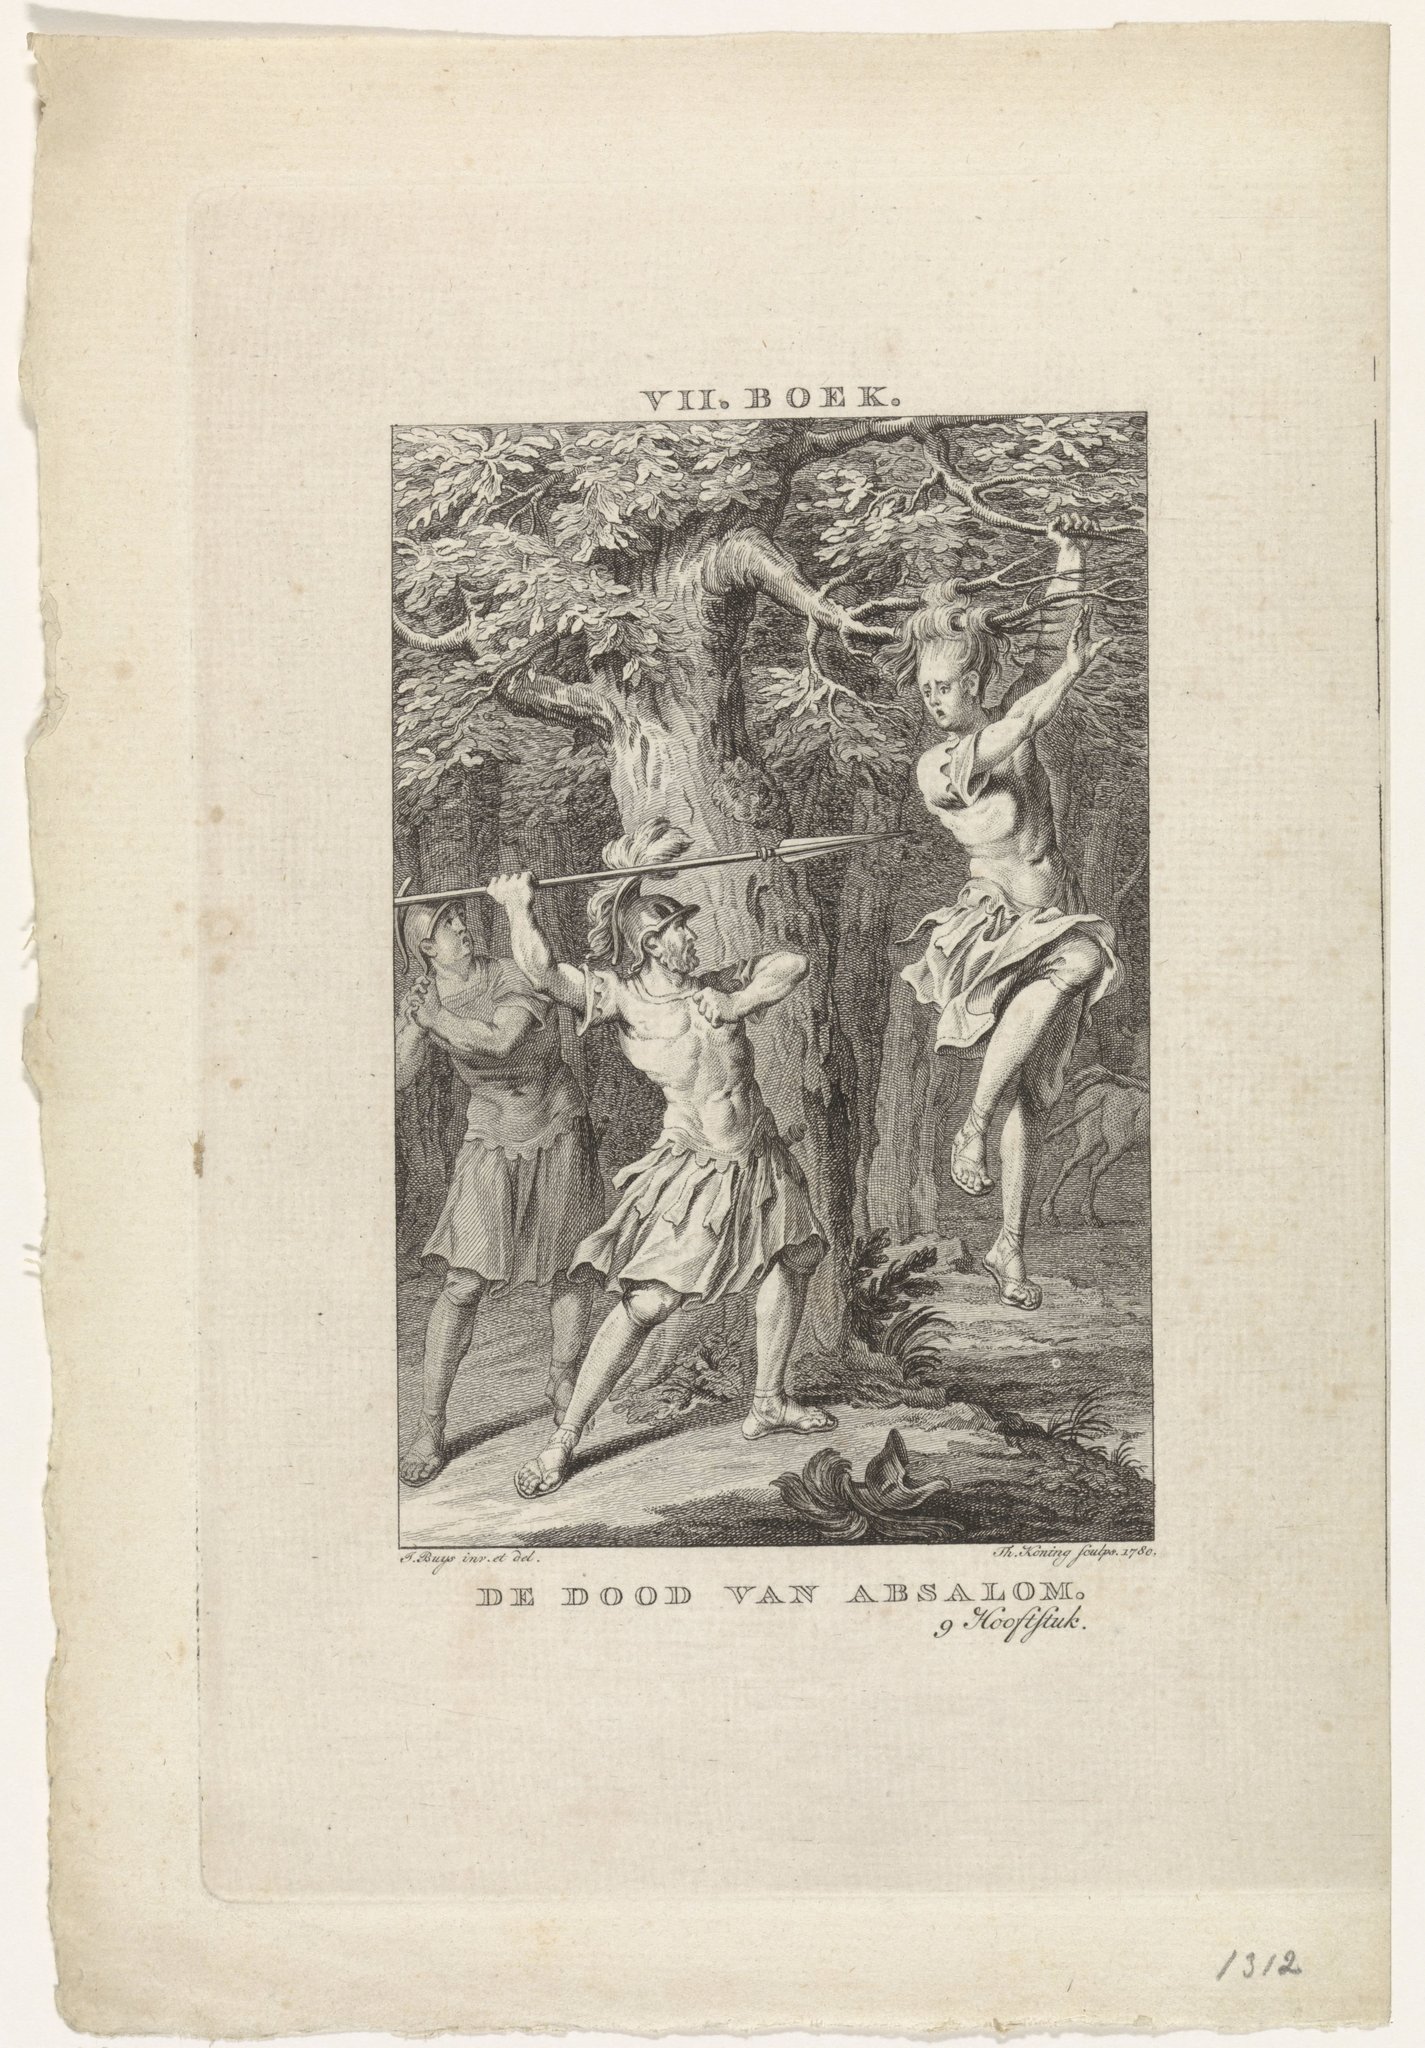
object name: book illustration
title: Dood van Absalom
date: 1780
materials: paper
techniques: engraving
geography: amsterdam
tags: absalom, put to flight on a mule, remains hanging by his hair in an oak-tree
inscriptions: collector's mark: Lugt 2228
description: In een bos hangt Absalom met zijn haren aan een boomtak, zijn helm ligt op de grond voor hem. Joab, de legeraanvoerder van koning David, staat op het punt om Absalom met zijn lans te doorsteken. Deze prent is een illustratie bij het negende hoofdstuk van het zevende boek van 'Alle de werken van Flavius Josephus'.